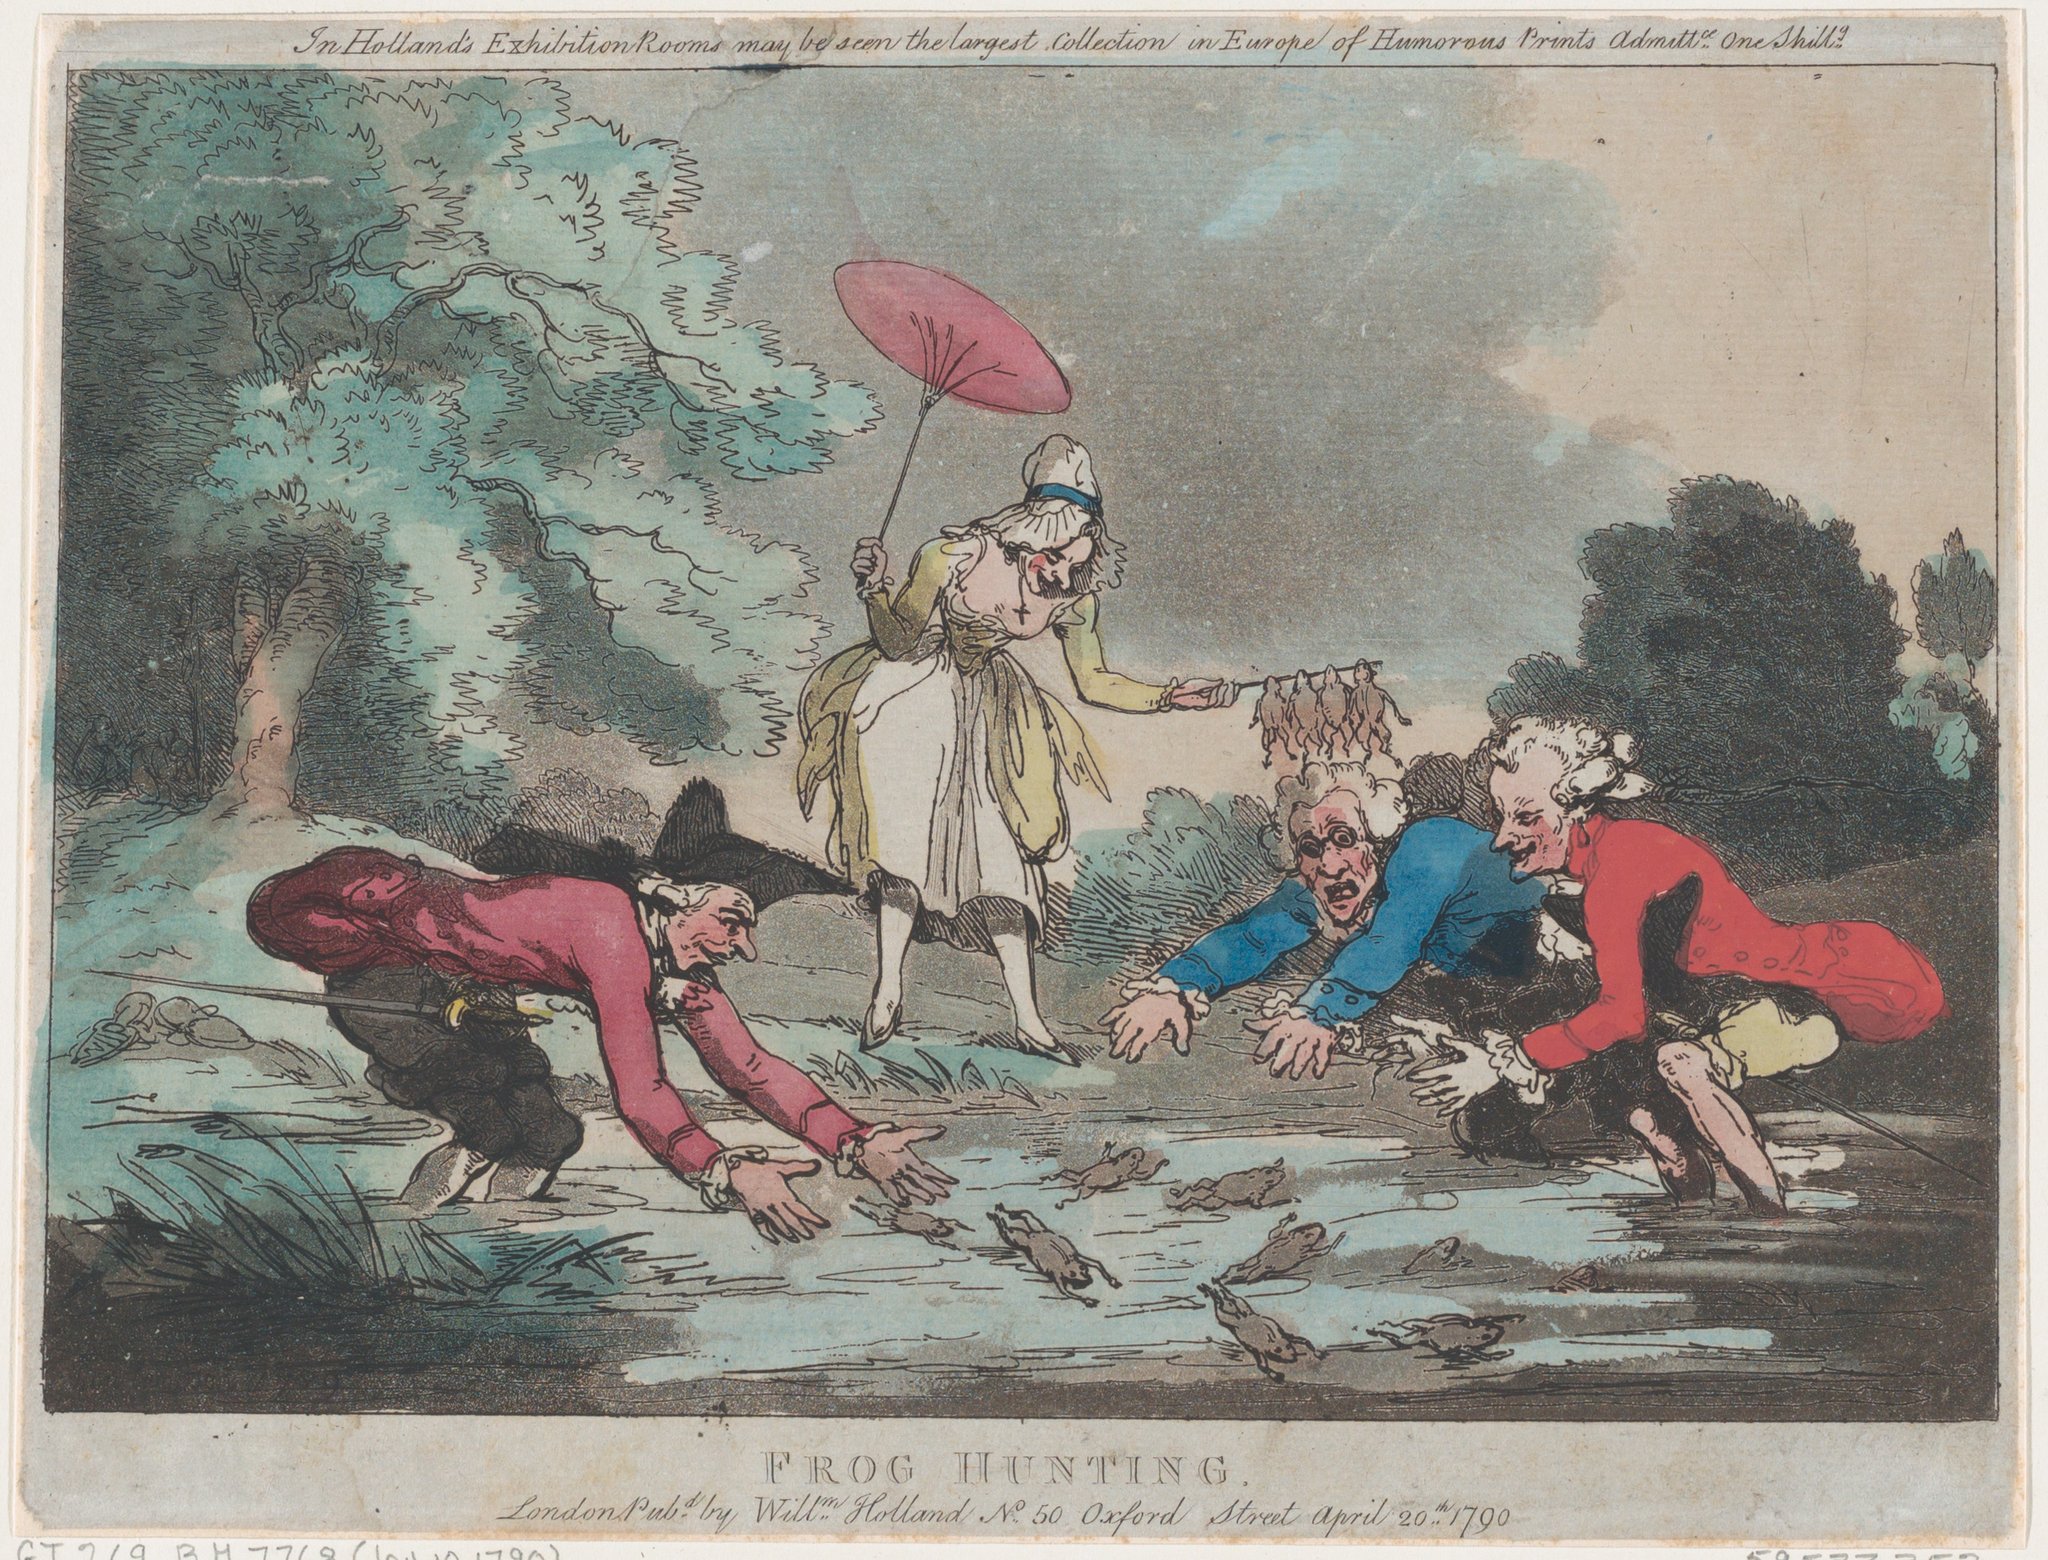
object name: print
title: Frog Hunting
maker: thomas rowlandson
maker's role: artist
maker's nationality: british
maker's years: 1757-1827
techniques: aquatint, etching, hand coloring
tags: satire,men,women,frogs